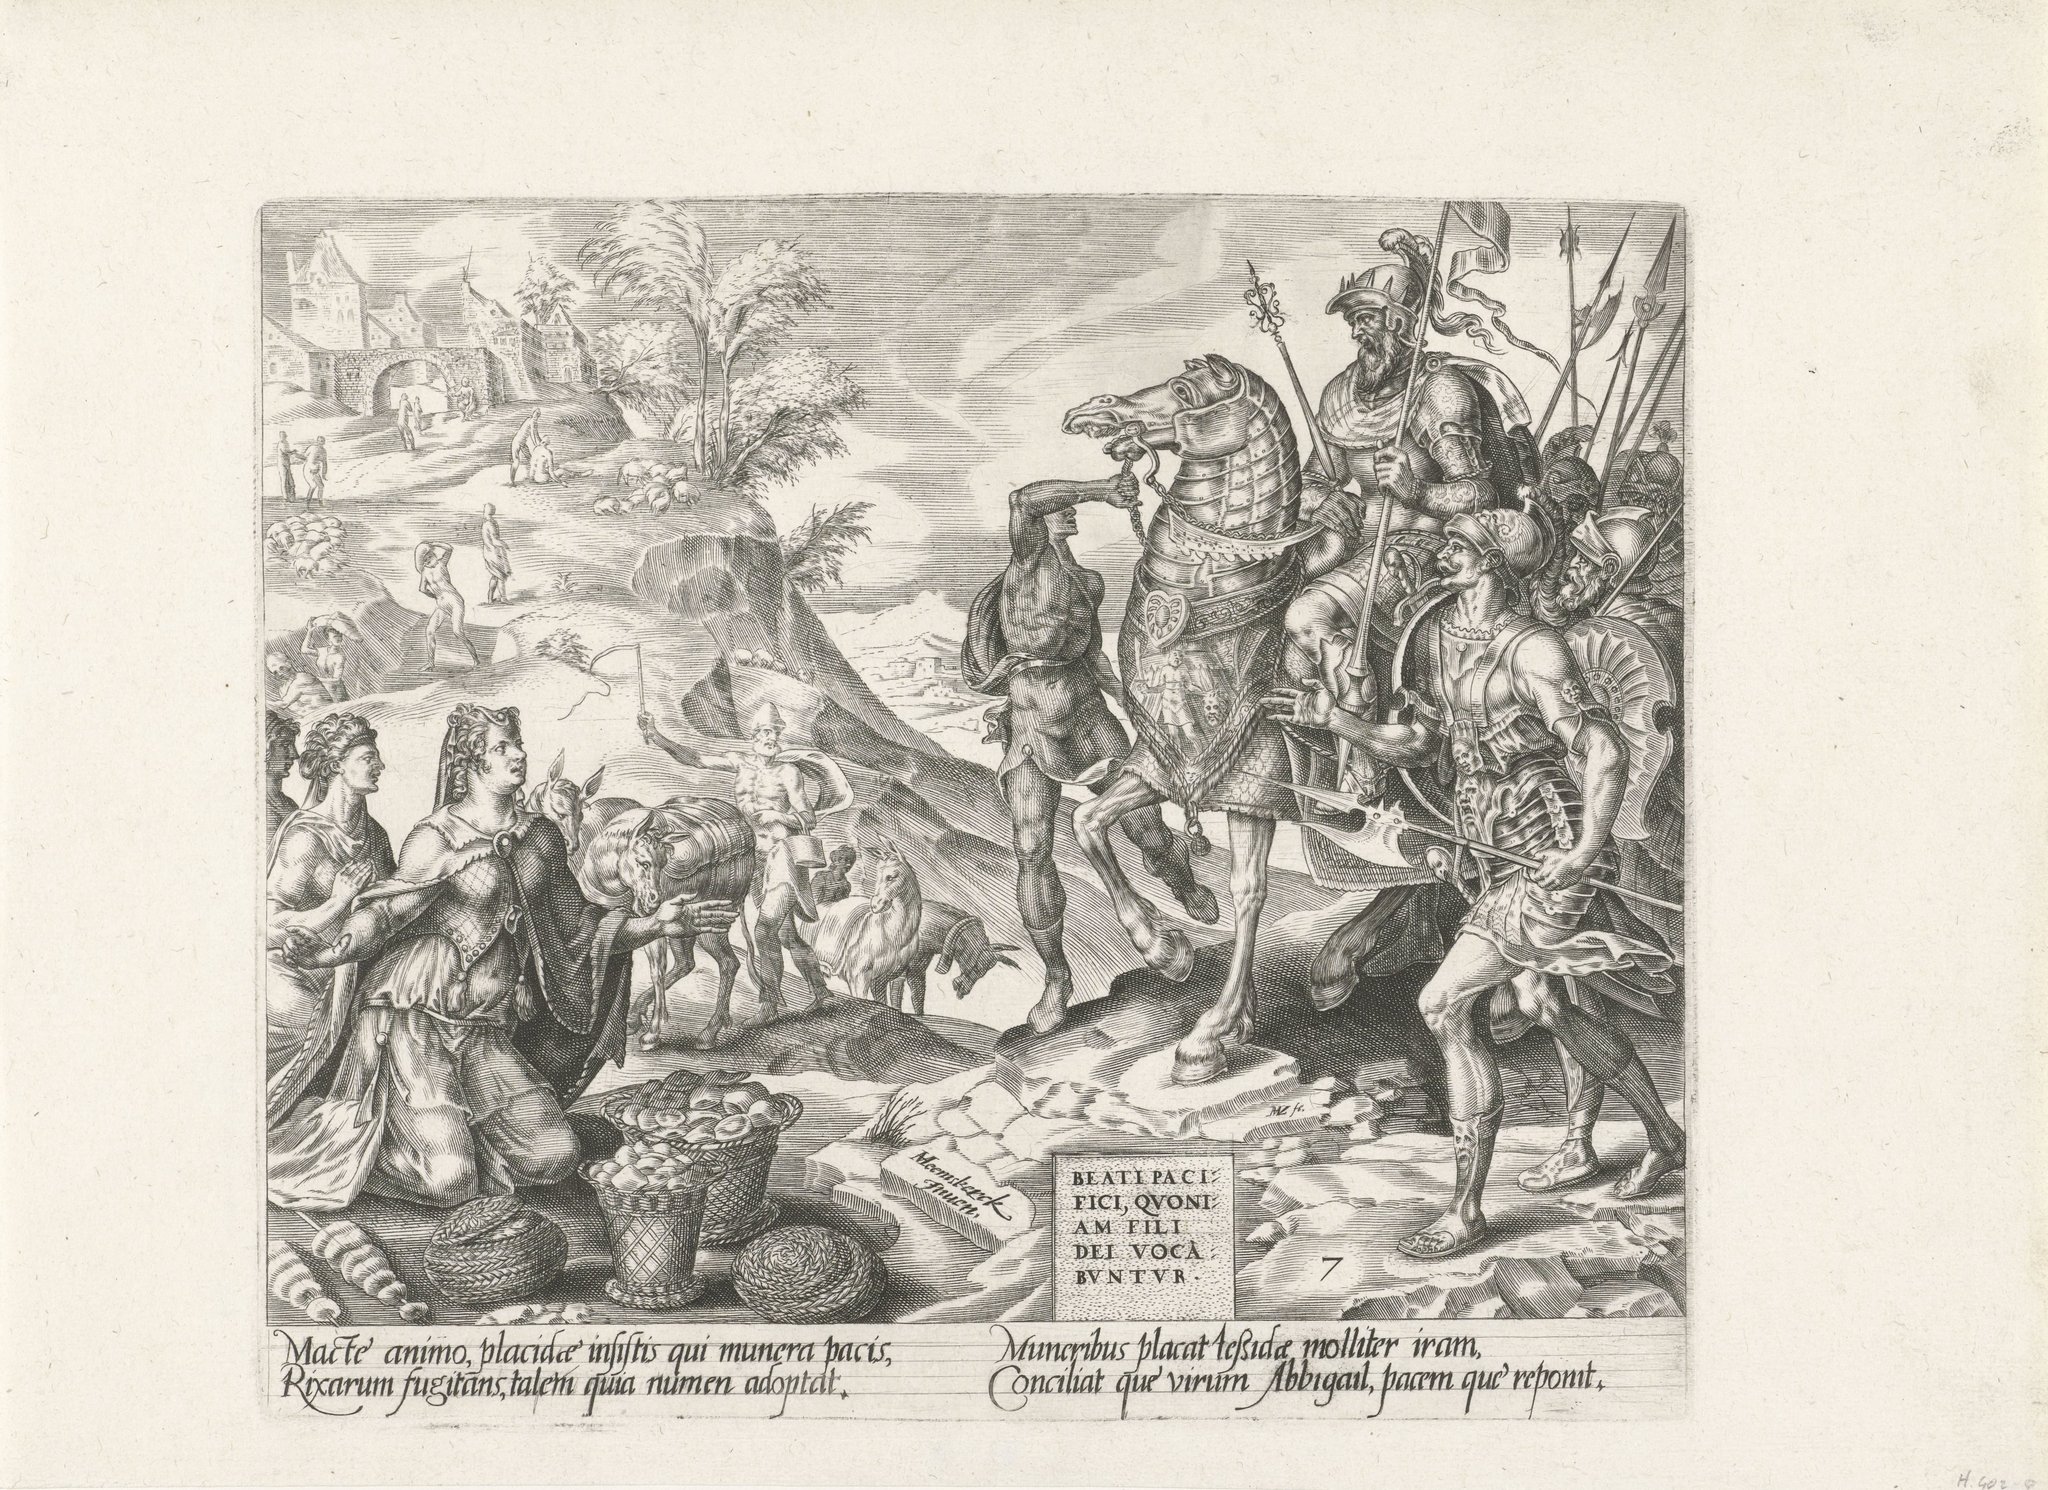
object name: print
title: De acht zaligsprekingen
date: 1564-1568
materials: paper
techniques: engraving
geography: amsterdam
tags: blessed are the peacemakers, meeting of david and abigail, who kneels before him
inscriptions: collector's mark: Lugt 2228, collector's mark: Lugt 2760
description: Wanneer een gierige boer weigert David en zijn manschappen te helpen, dreigen ze hem te straffen. Abigaïl, de vrouw van de boer, knielt voor David en biedt hem en zijn soldaten eten en drinken aan. Daarmee stemde ze David tevreden. Prent maakt deel uit van een serie over de acht zaligsprekingen van Christus en illustreert de zaligspreking: Zalig de vredestichters. Op een vierkant plakaat onderaan deze tekst uit Mat. 5:9 in het Latijn. Onderaan in de marge een vers in het Latijn over de zaligspreking en de voorstelling.